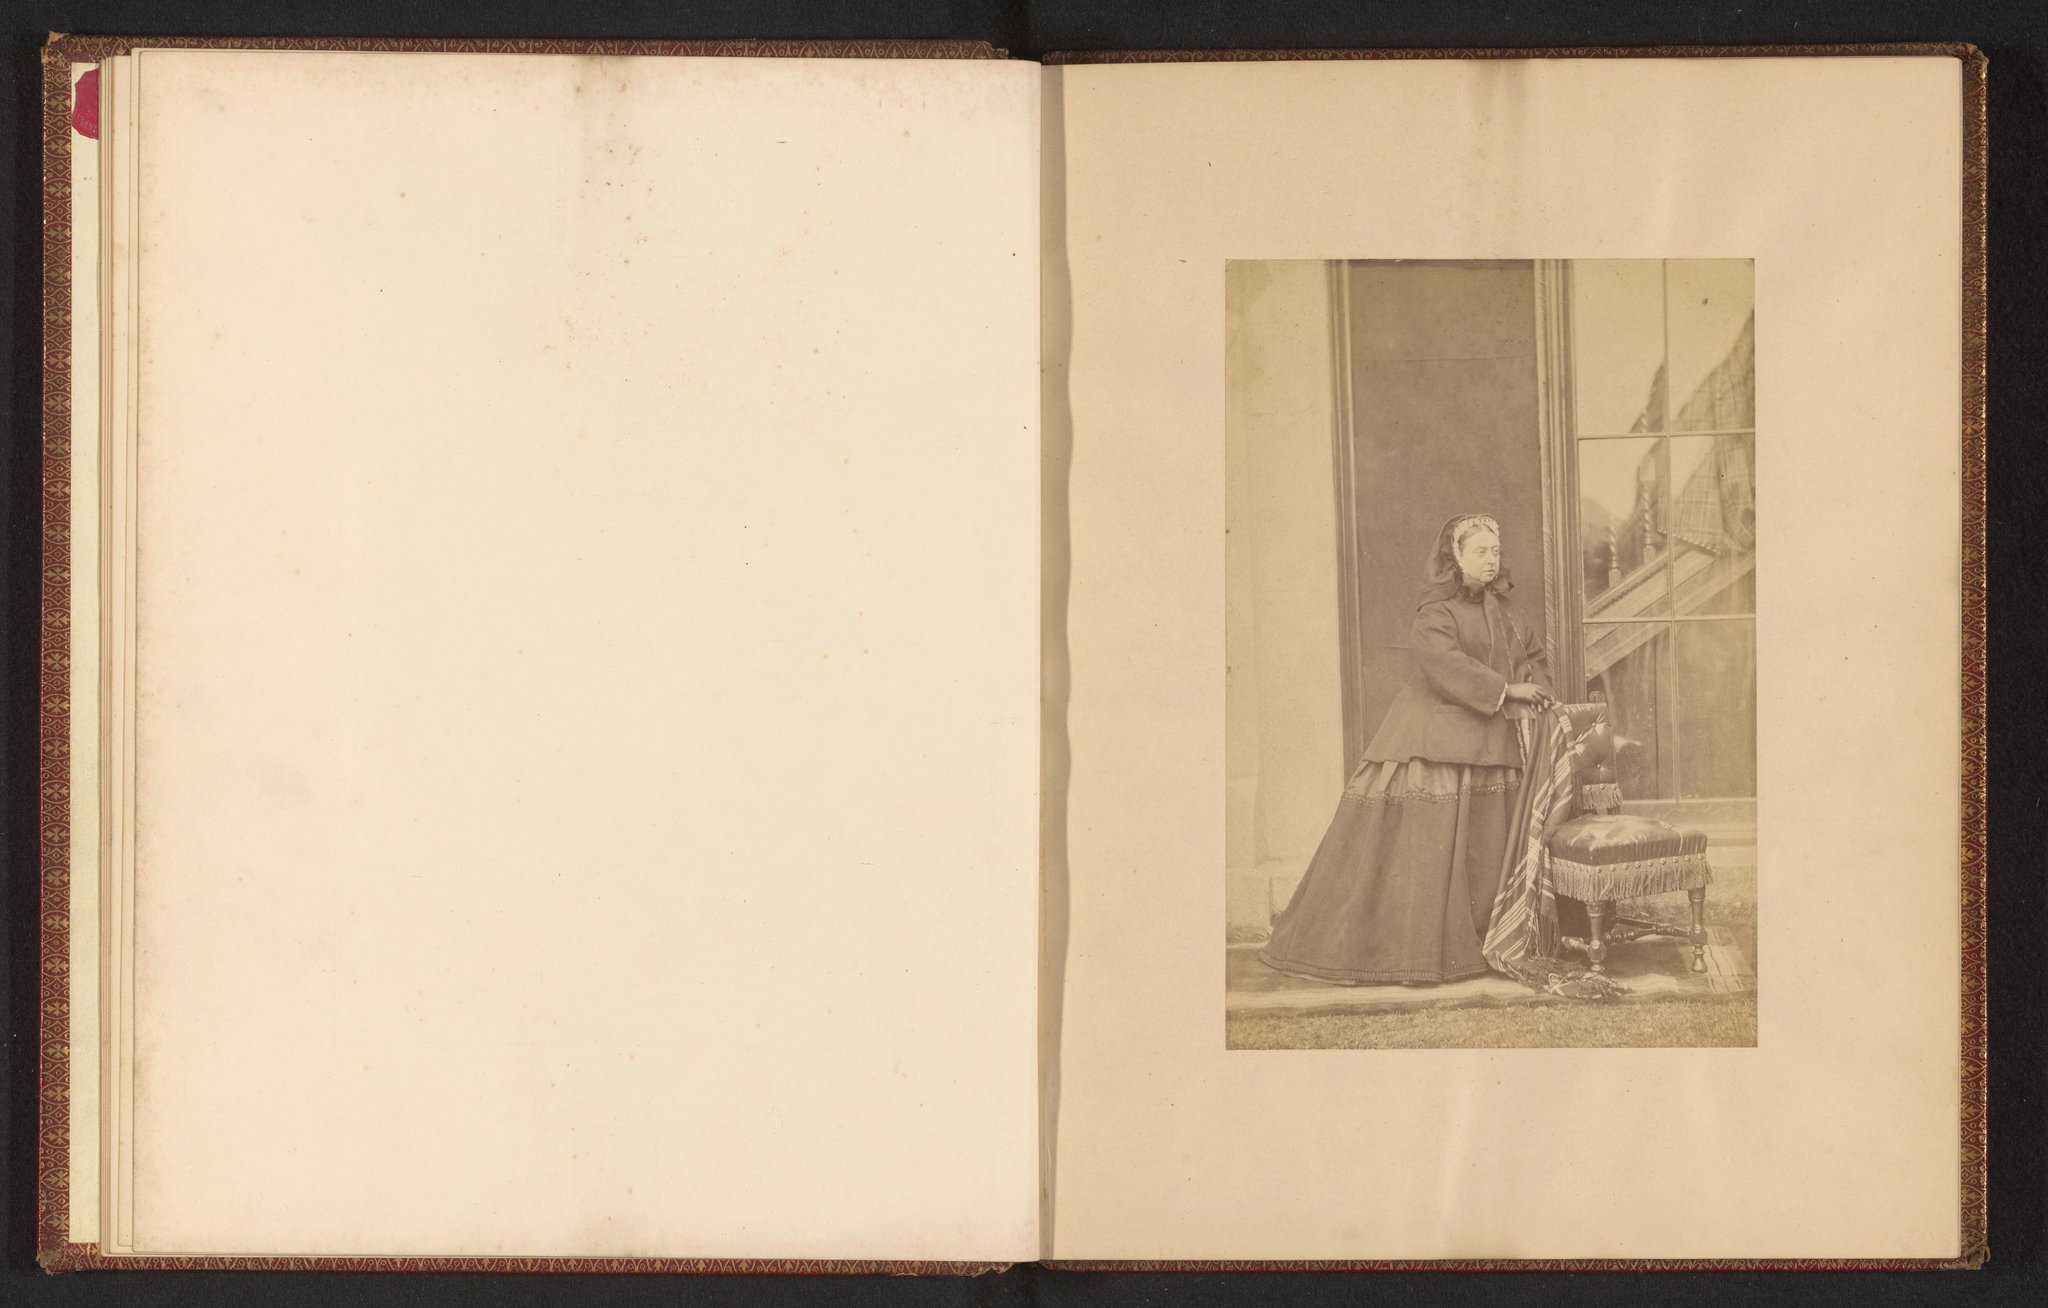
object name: photograph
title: Portret van koningin Victoria van het Verenigd Koninkrijk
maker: Anonymous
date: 1866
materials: photographic support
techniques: albumen print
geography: wolverhampton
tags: victoria (koningin van het verenigd koninkrijk en keizerin van india), ruler, sovereign - bb - female ruler